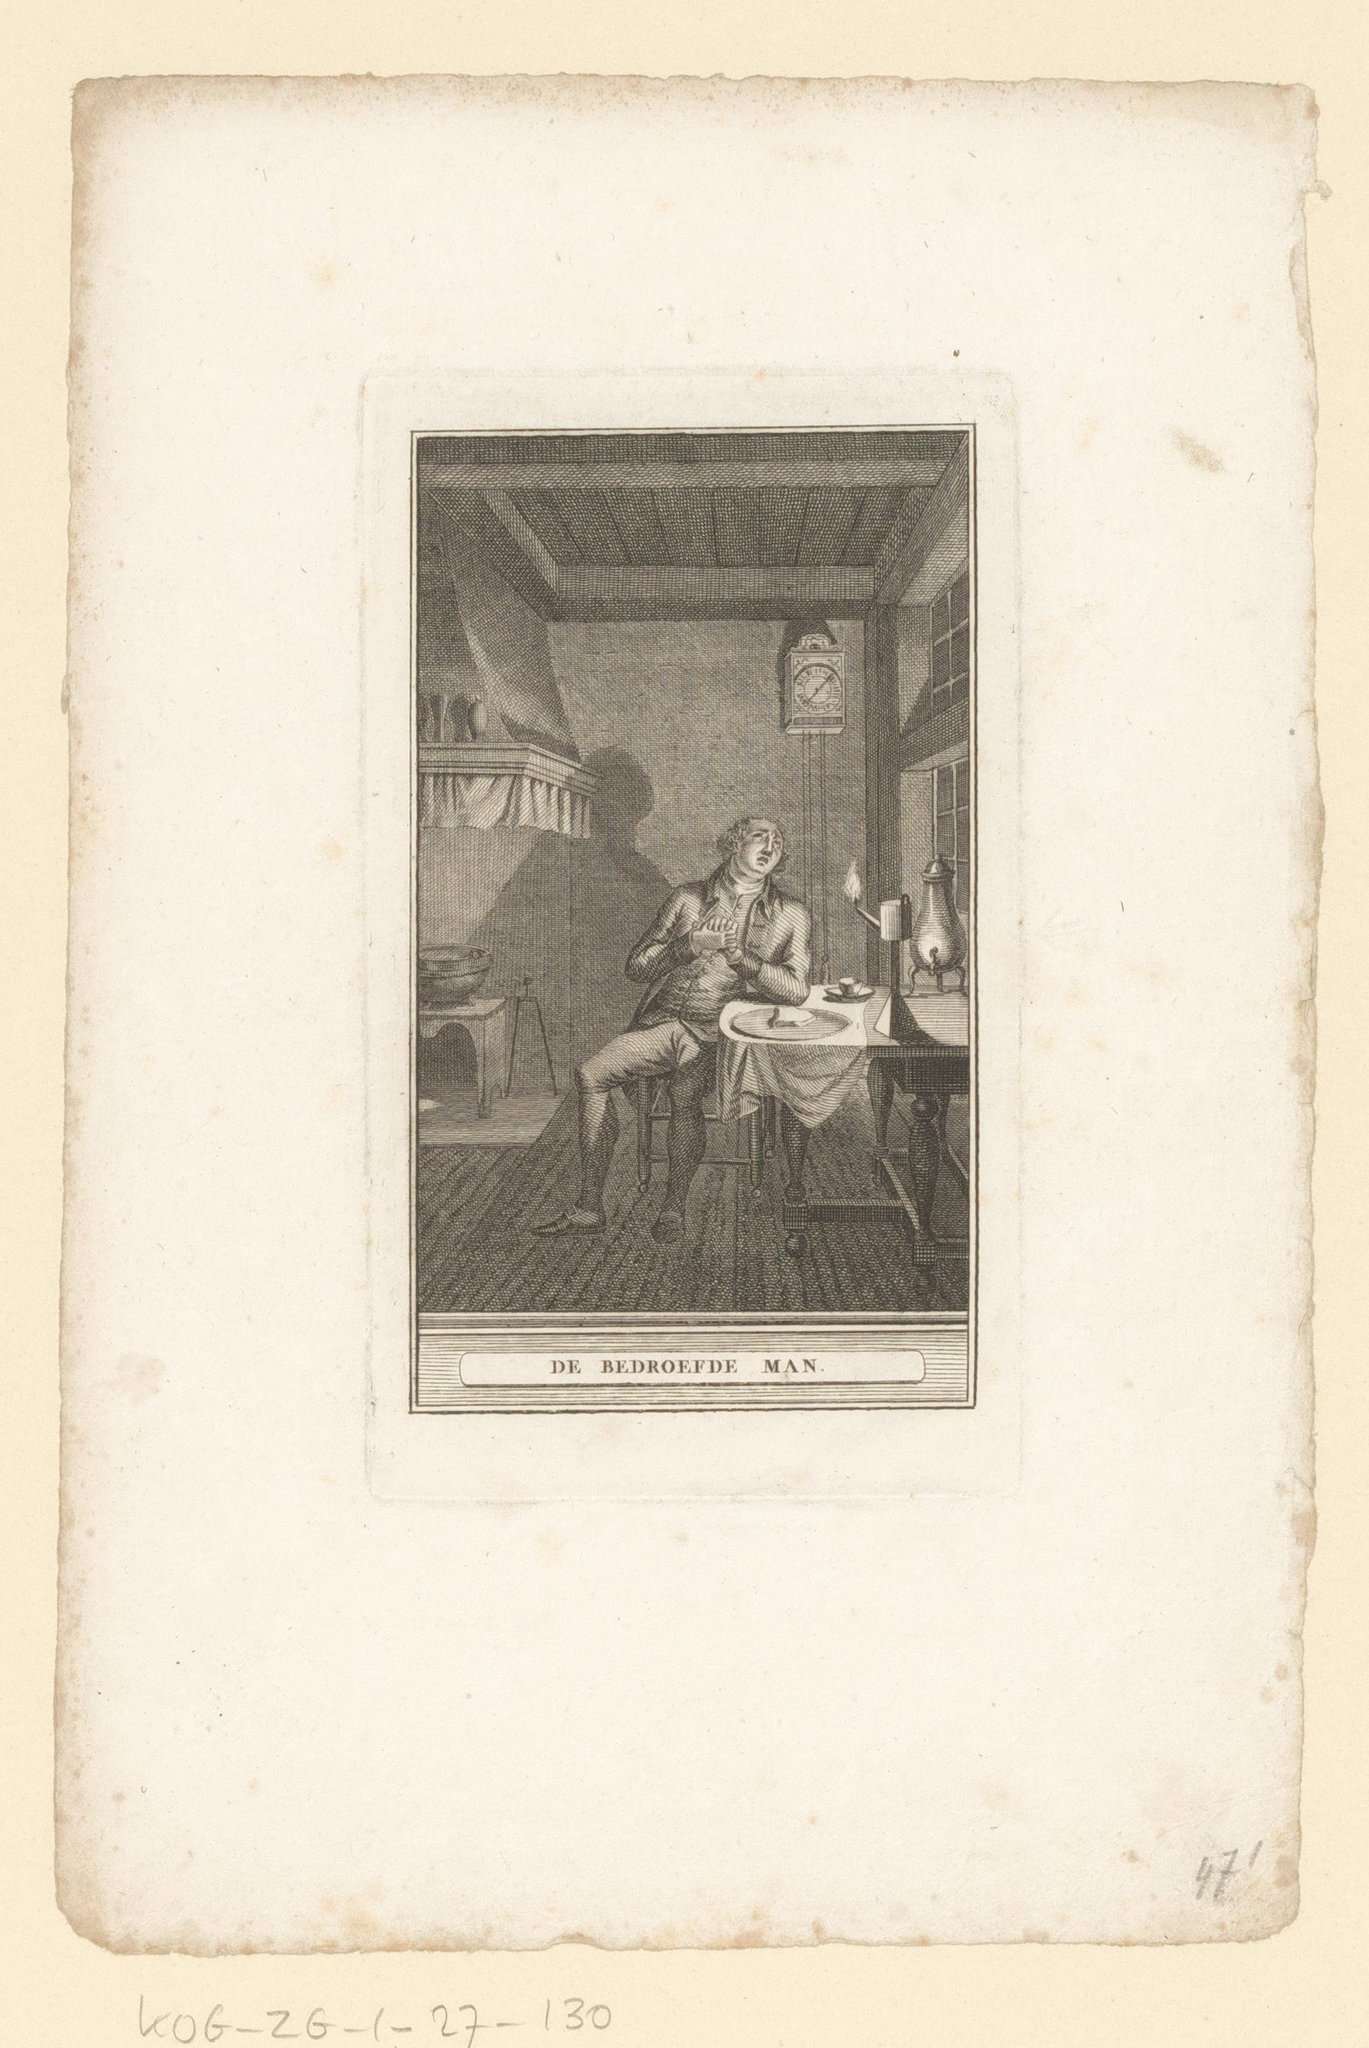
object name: book illustration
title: De bedroefde man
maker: Anonymous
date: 1792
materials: paper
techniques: engraving, etching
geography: netherlands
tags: kitchen, pain, sorrow, sadness; 'dolore', 'dolore di zeusi' (ripa), communal rooms, rubbing, wringing one's hands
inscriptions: collector's mark: Lugt 1641, collector's mark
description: Gebruikt als illustratie in: E. Bekker en A. Deken, Economische liedjes, Den Haag: Isaac van Cleef, 1792, dl. 1. p. 27.